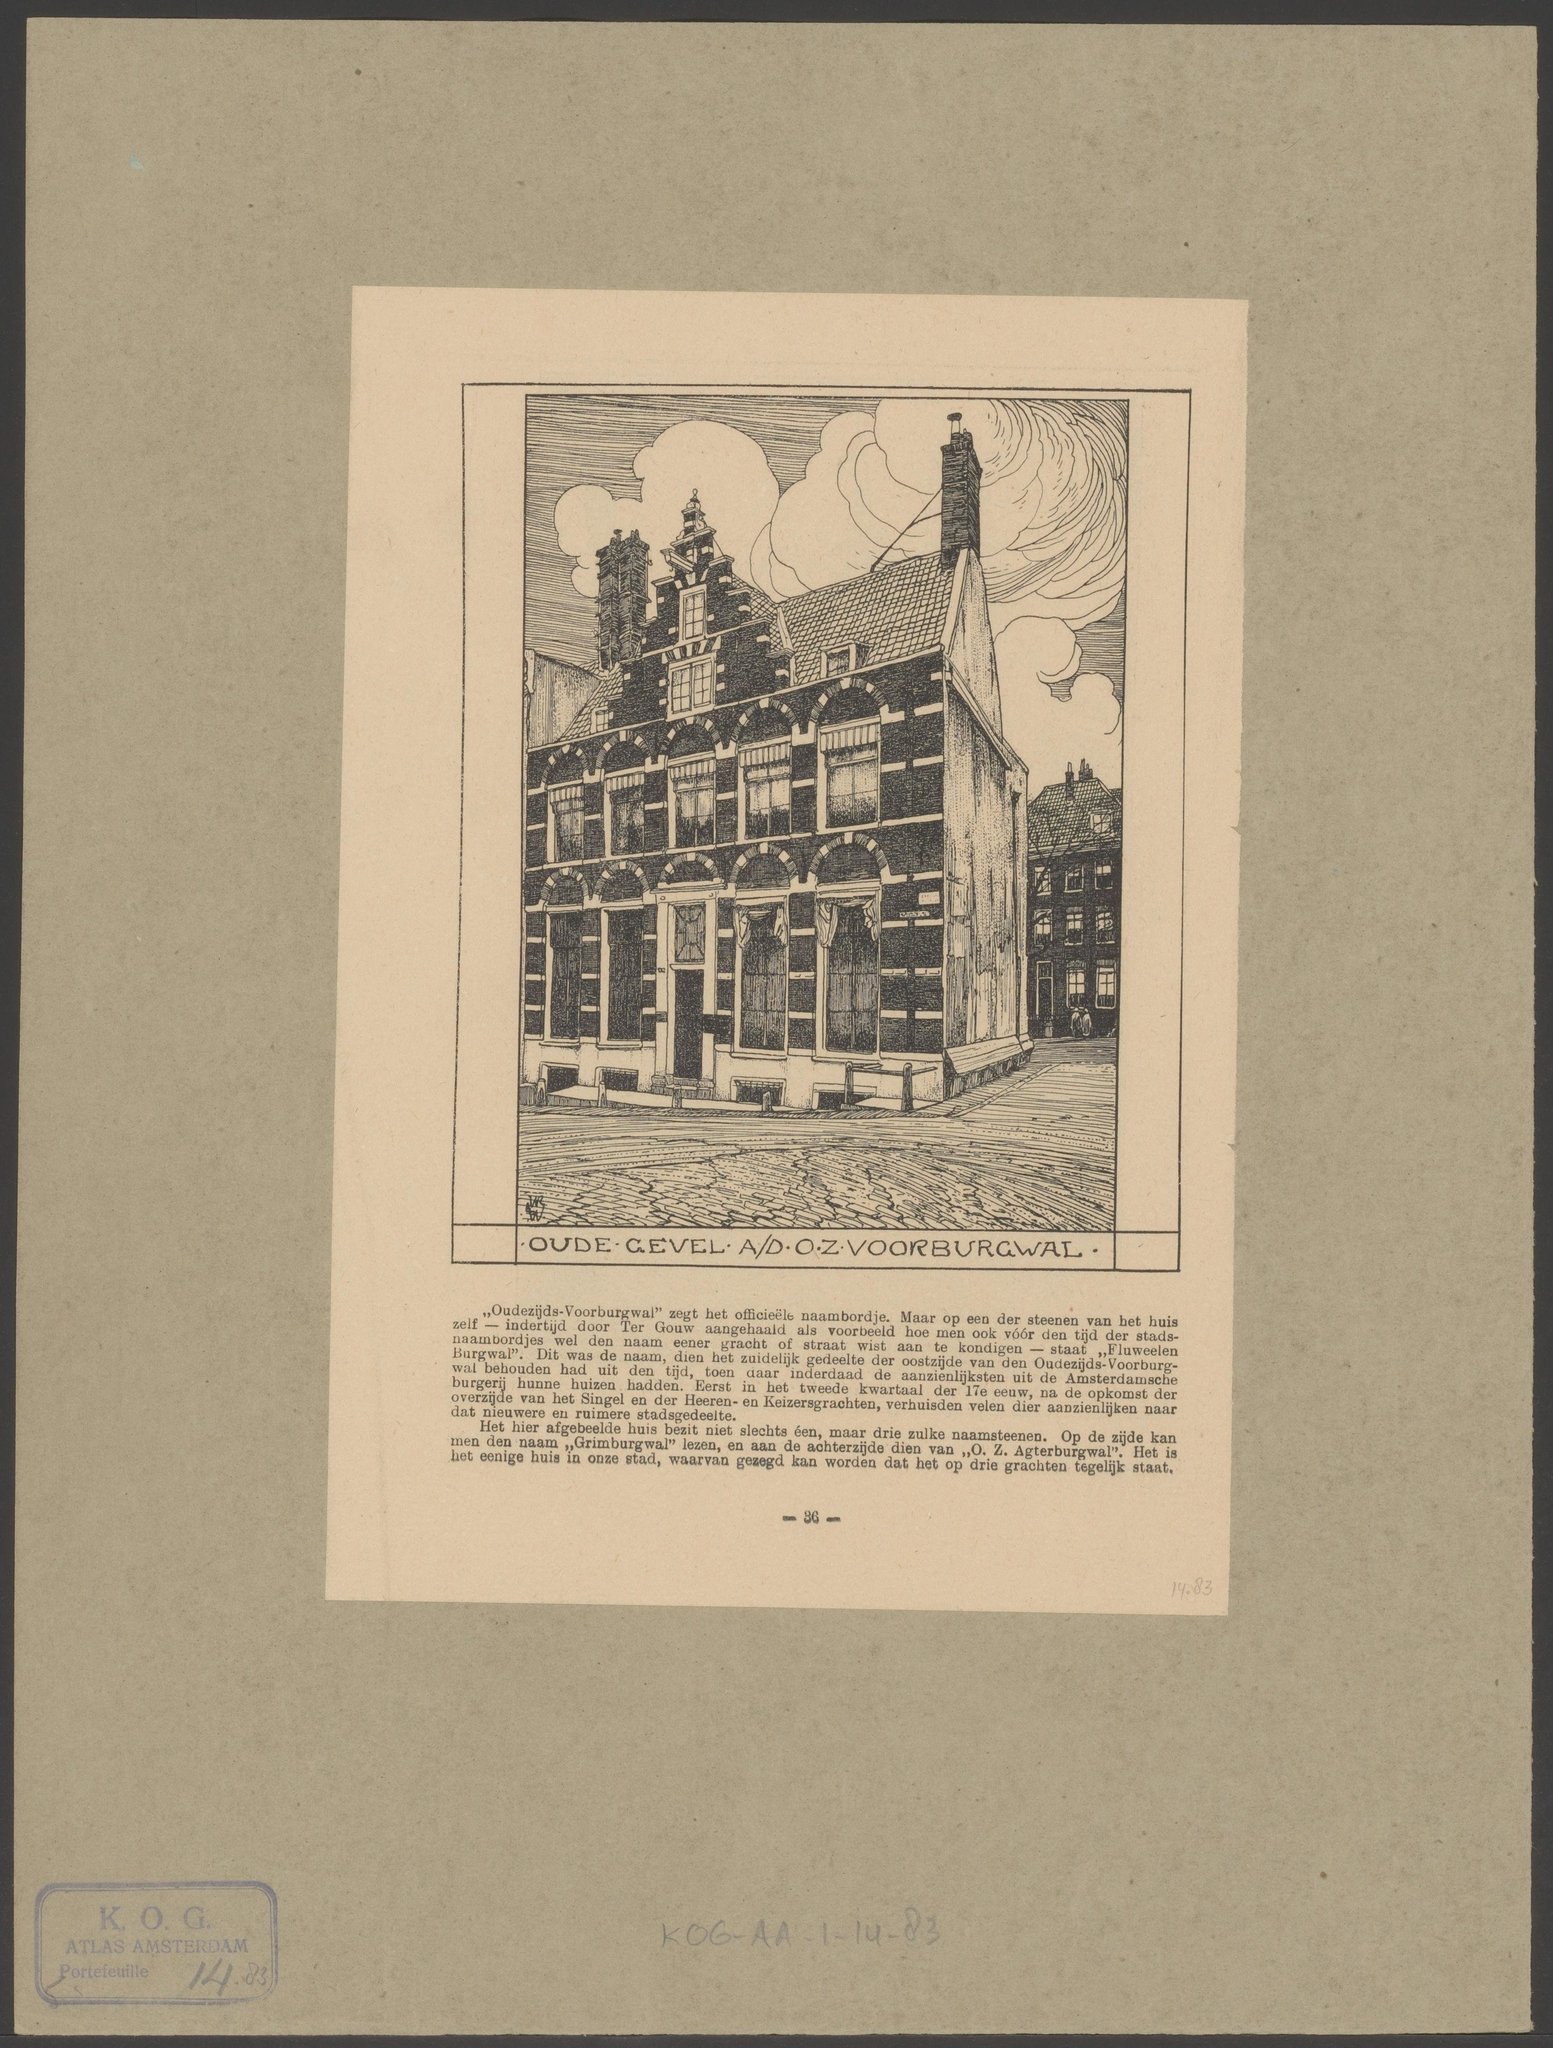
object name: page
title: Gezicht op een gevel van een pand aan de Oudezijds Voorburgwal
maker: willem wenckebach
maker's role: designer, draughtsman, painter, print maker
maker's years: 1860-1937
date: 1870-1923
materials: paper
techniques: letterpress printing, line block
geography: amsterdam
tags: city-view in general; 'veduta', the usual house or row of houses, façade (of house or building), street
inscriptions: collector's mark: ‘14.83’ Lugt 1641b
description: Fotomechanische afdruk uit een editie van Het Nieuws van den Dag, mogelijk uit de serie: Oud-Amsterdam 100 Stadsgezichten.